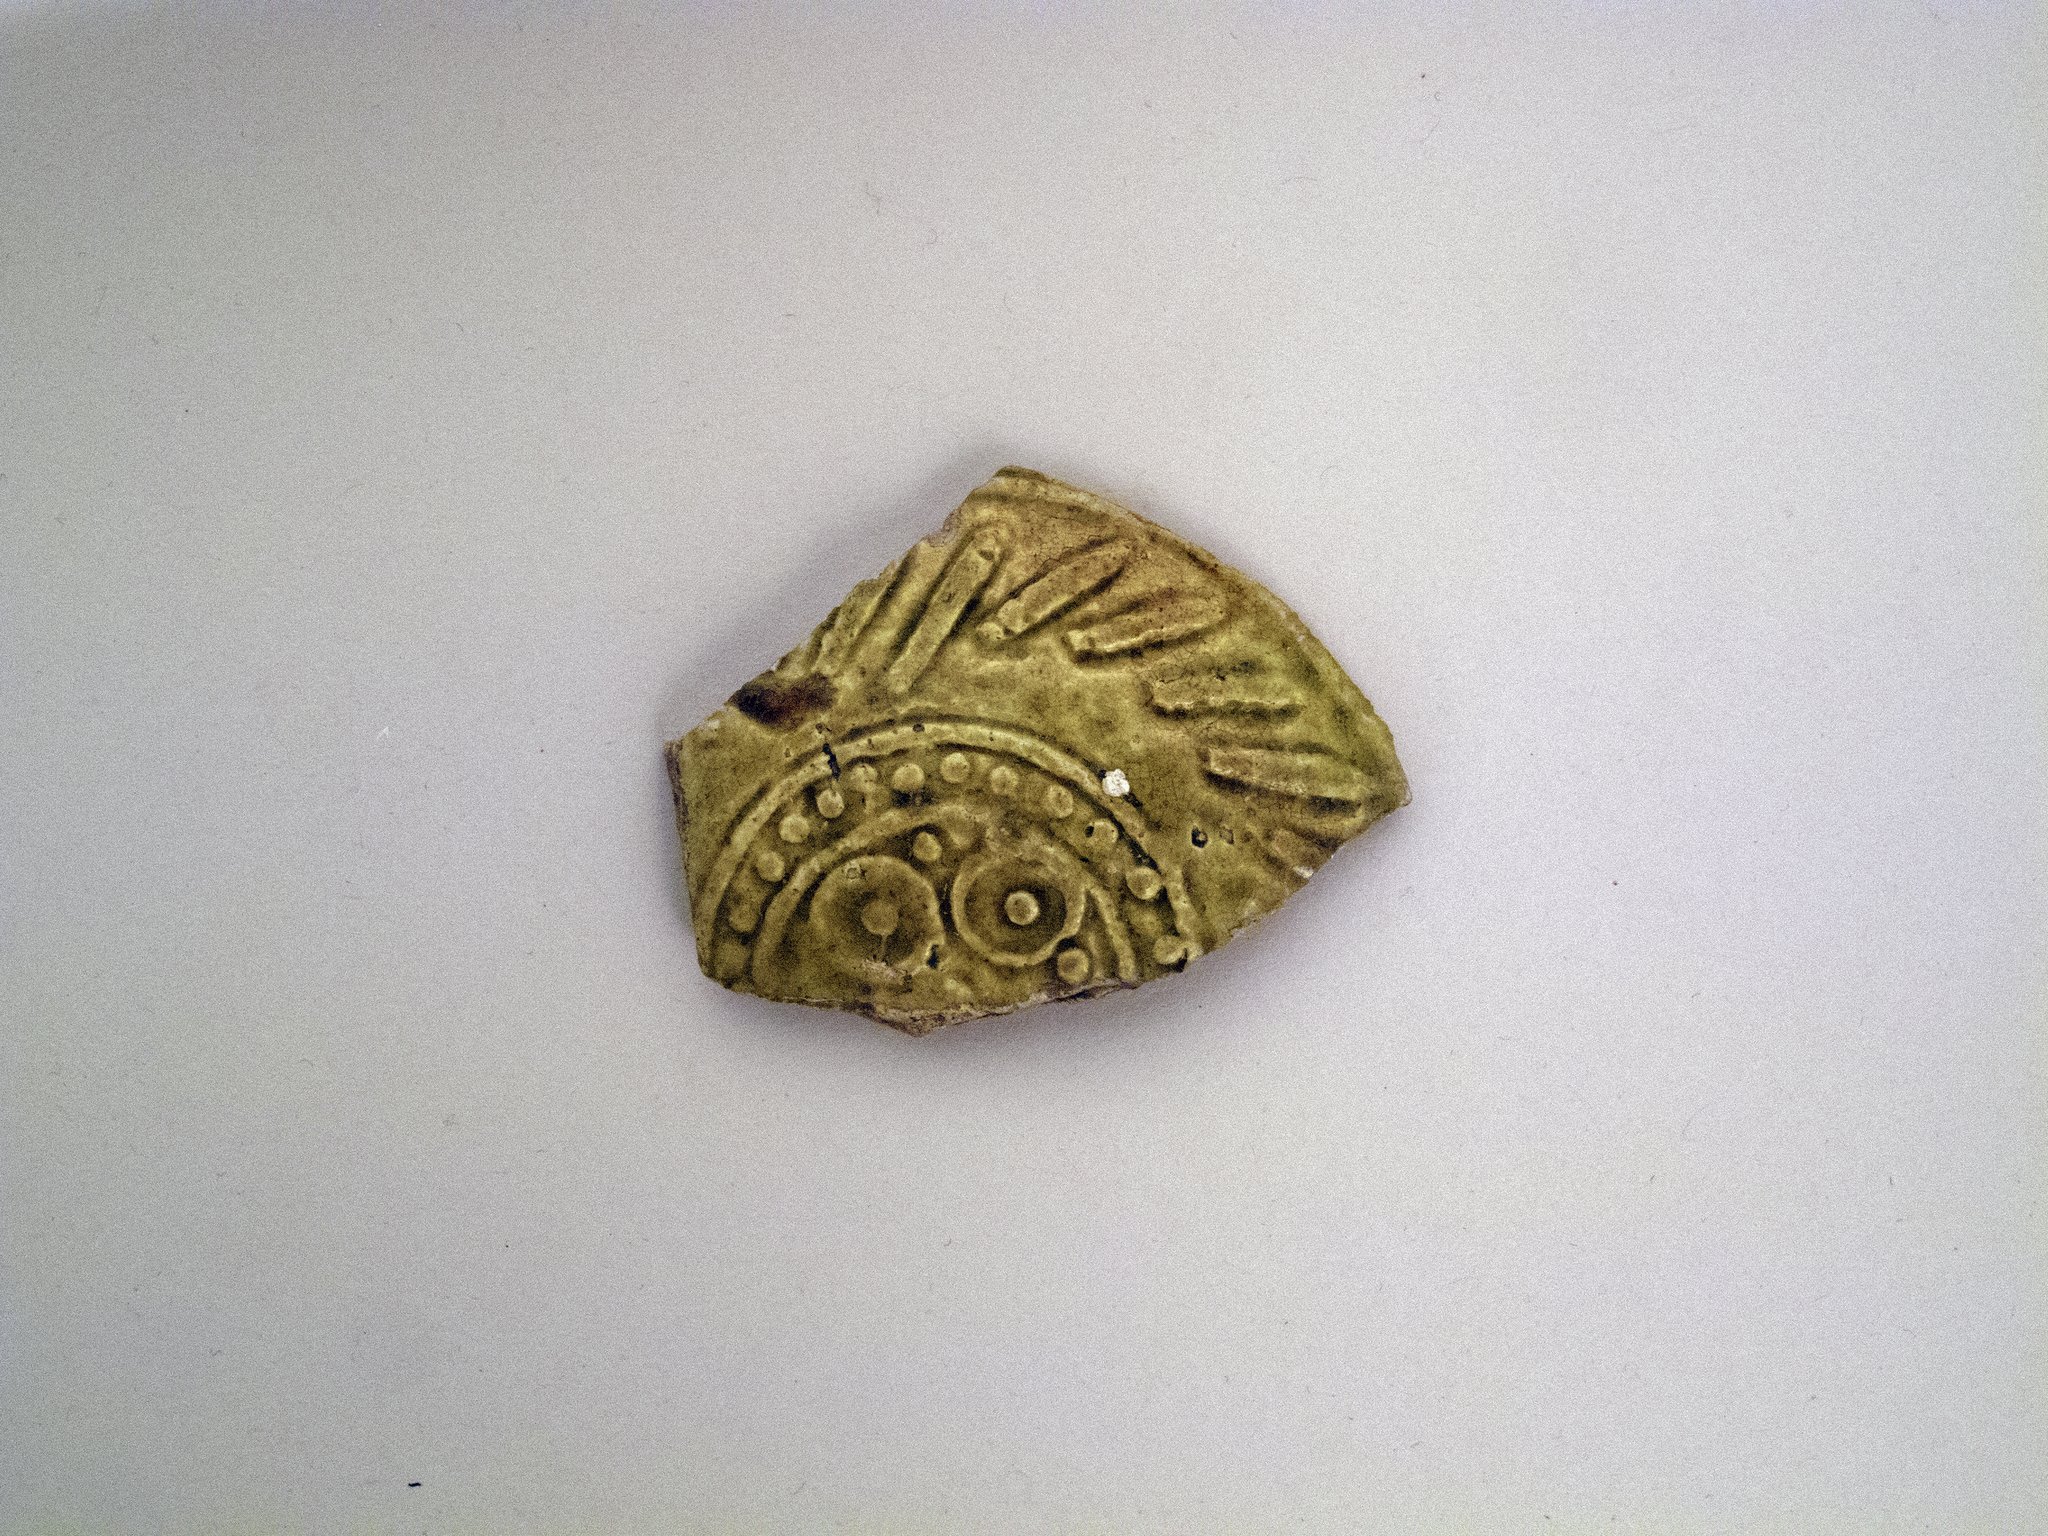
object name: vase fragment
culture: roman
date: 670 BCE-330 CE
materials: terracotta